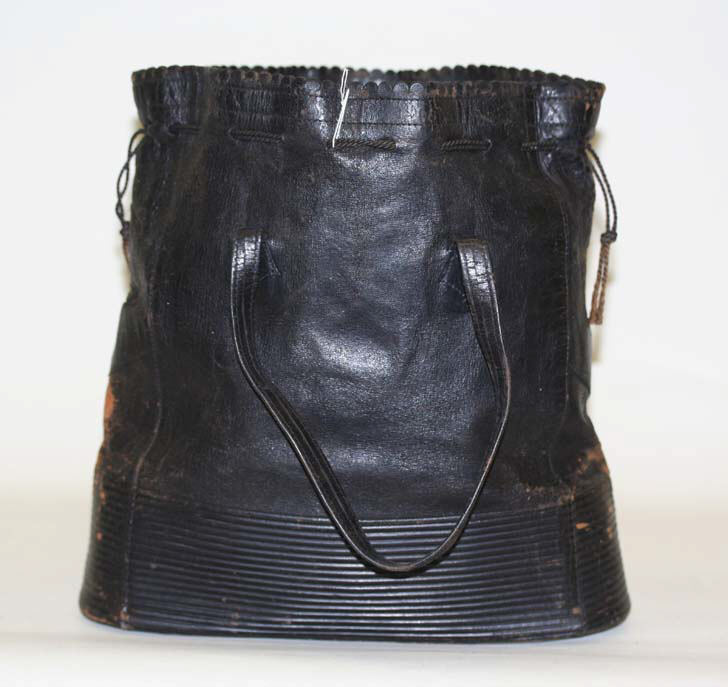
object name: drawstring bag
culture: american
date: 1890-1899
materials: cotton, leather